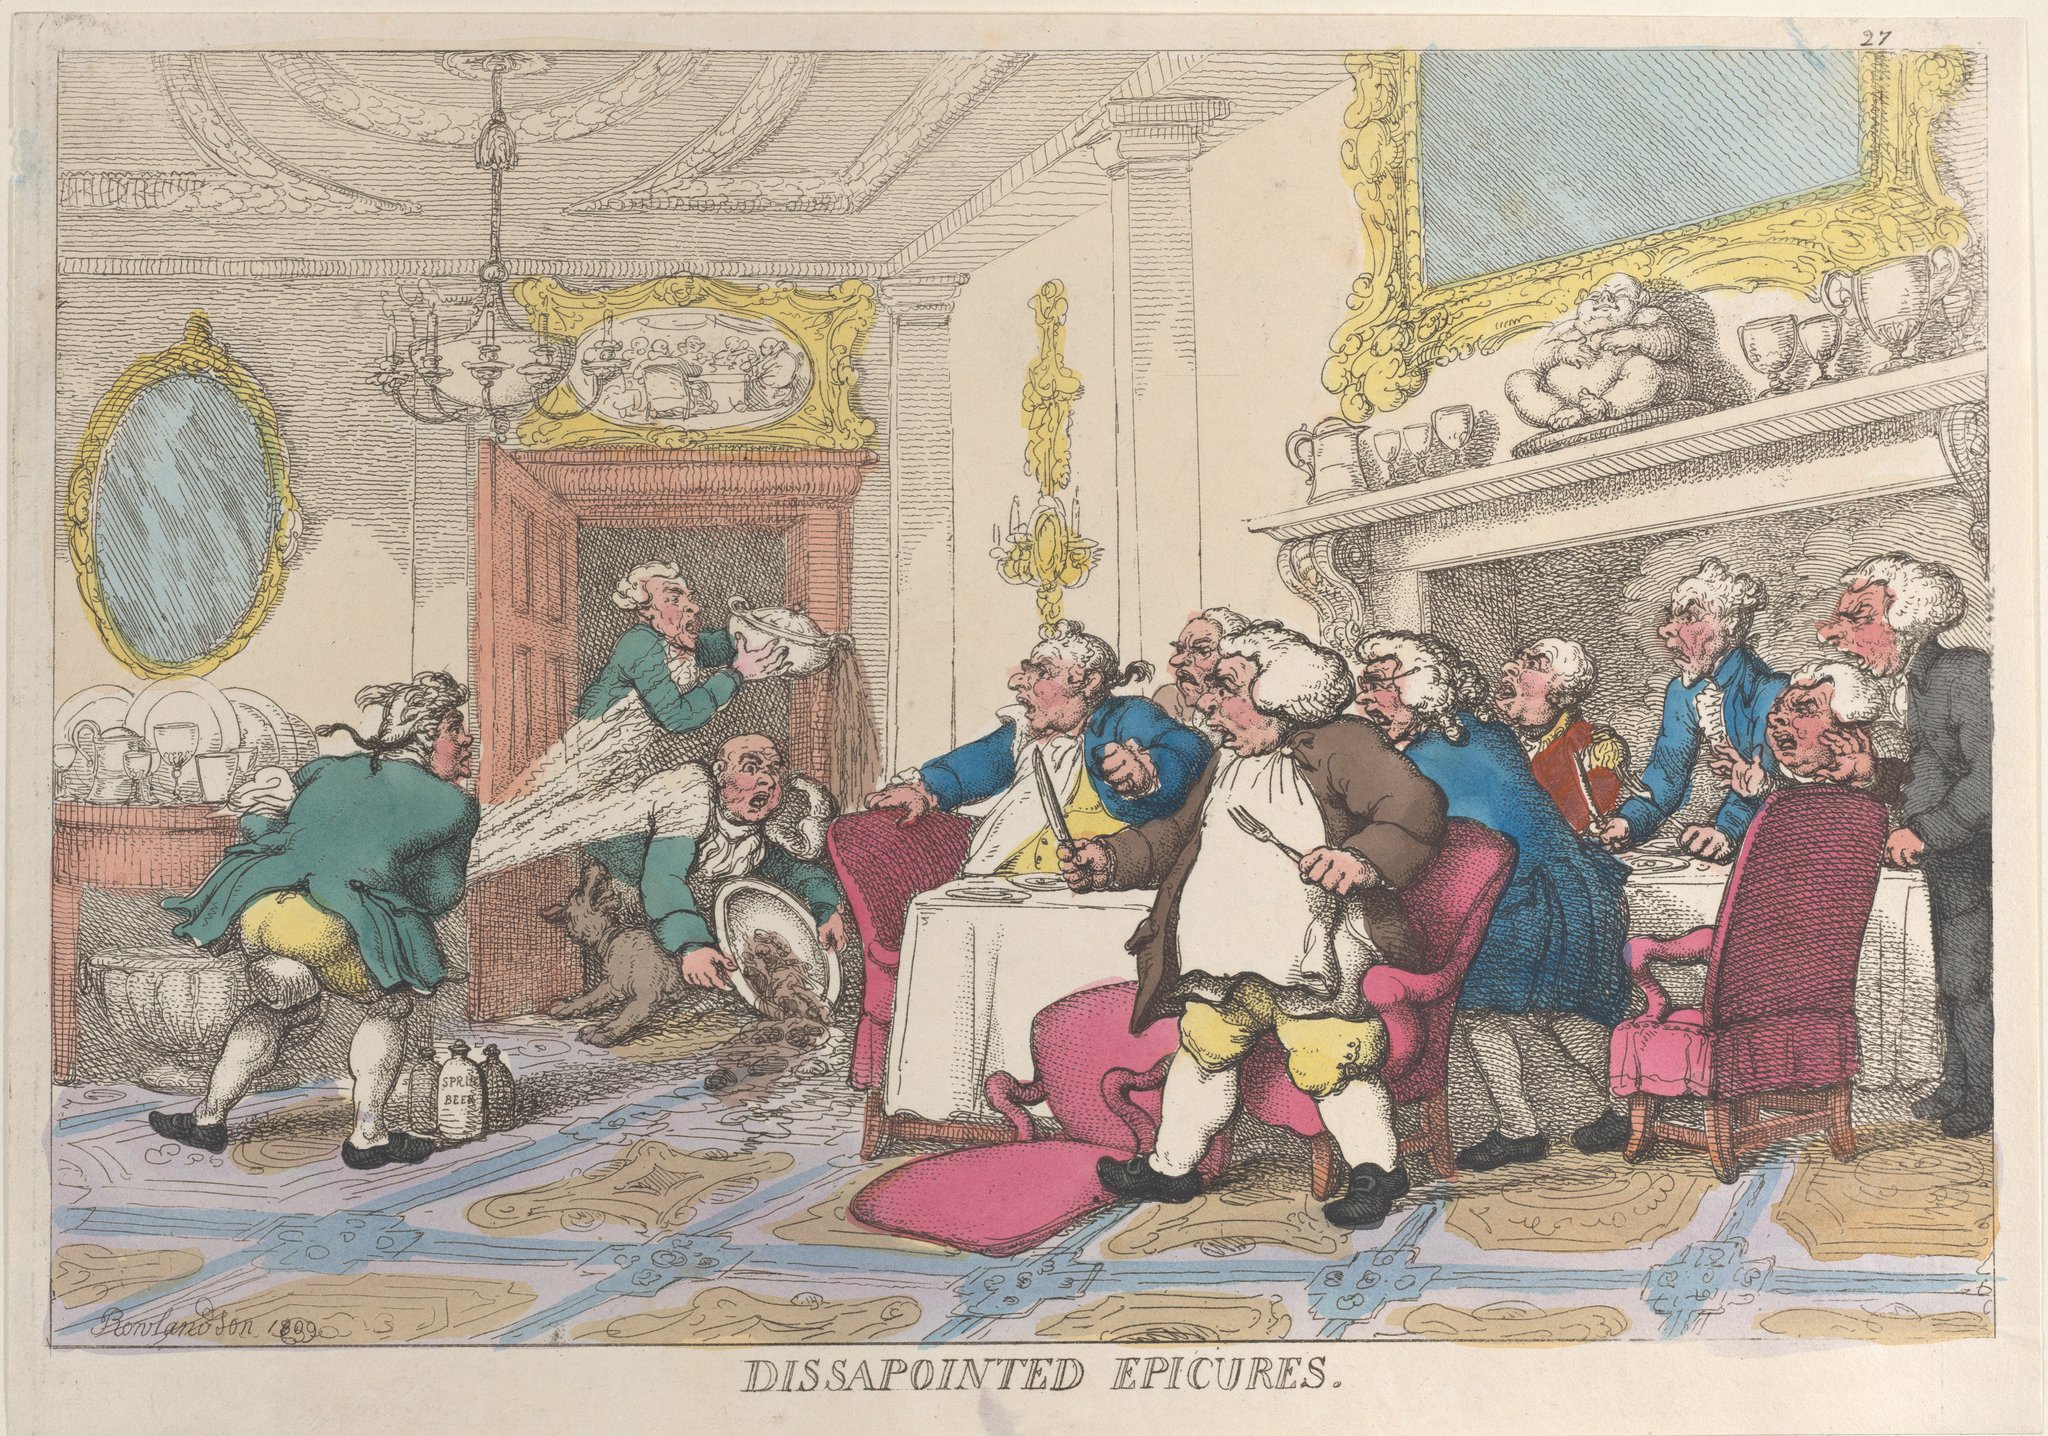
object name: print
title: Disappointed Epicures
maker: thomas rowlandson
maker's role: artist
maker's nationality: british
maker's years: 1757-1827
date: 1809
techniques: etching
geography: london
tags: satire,men,dogs,dining